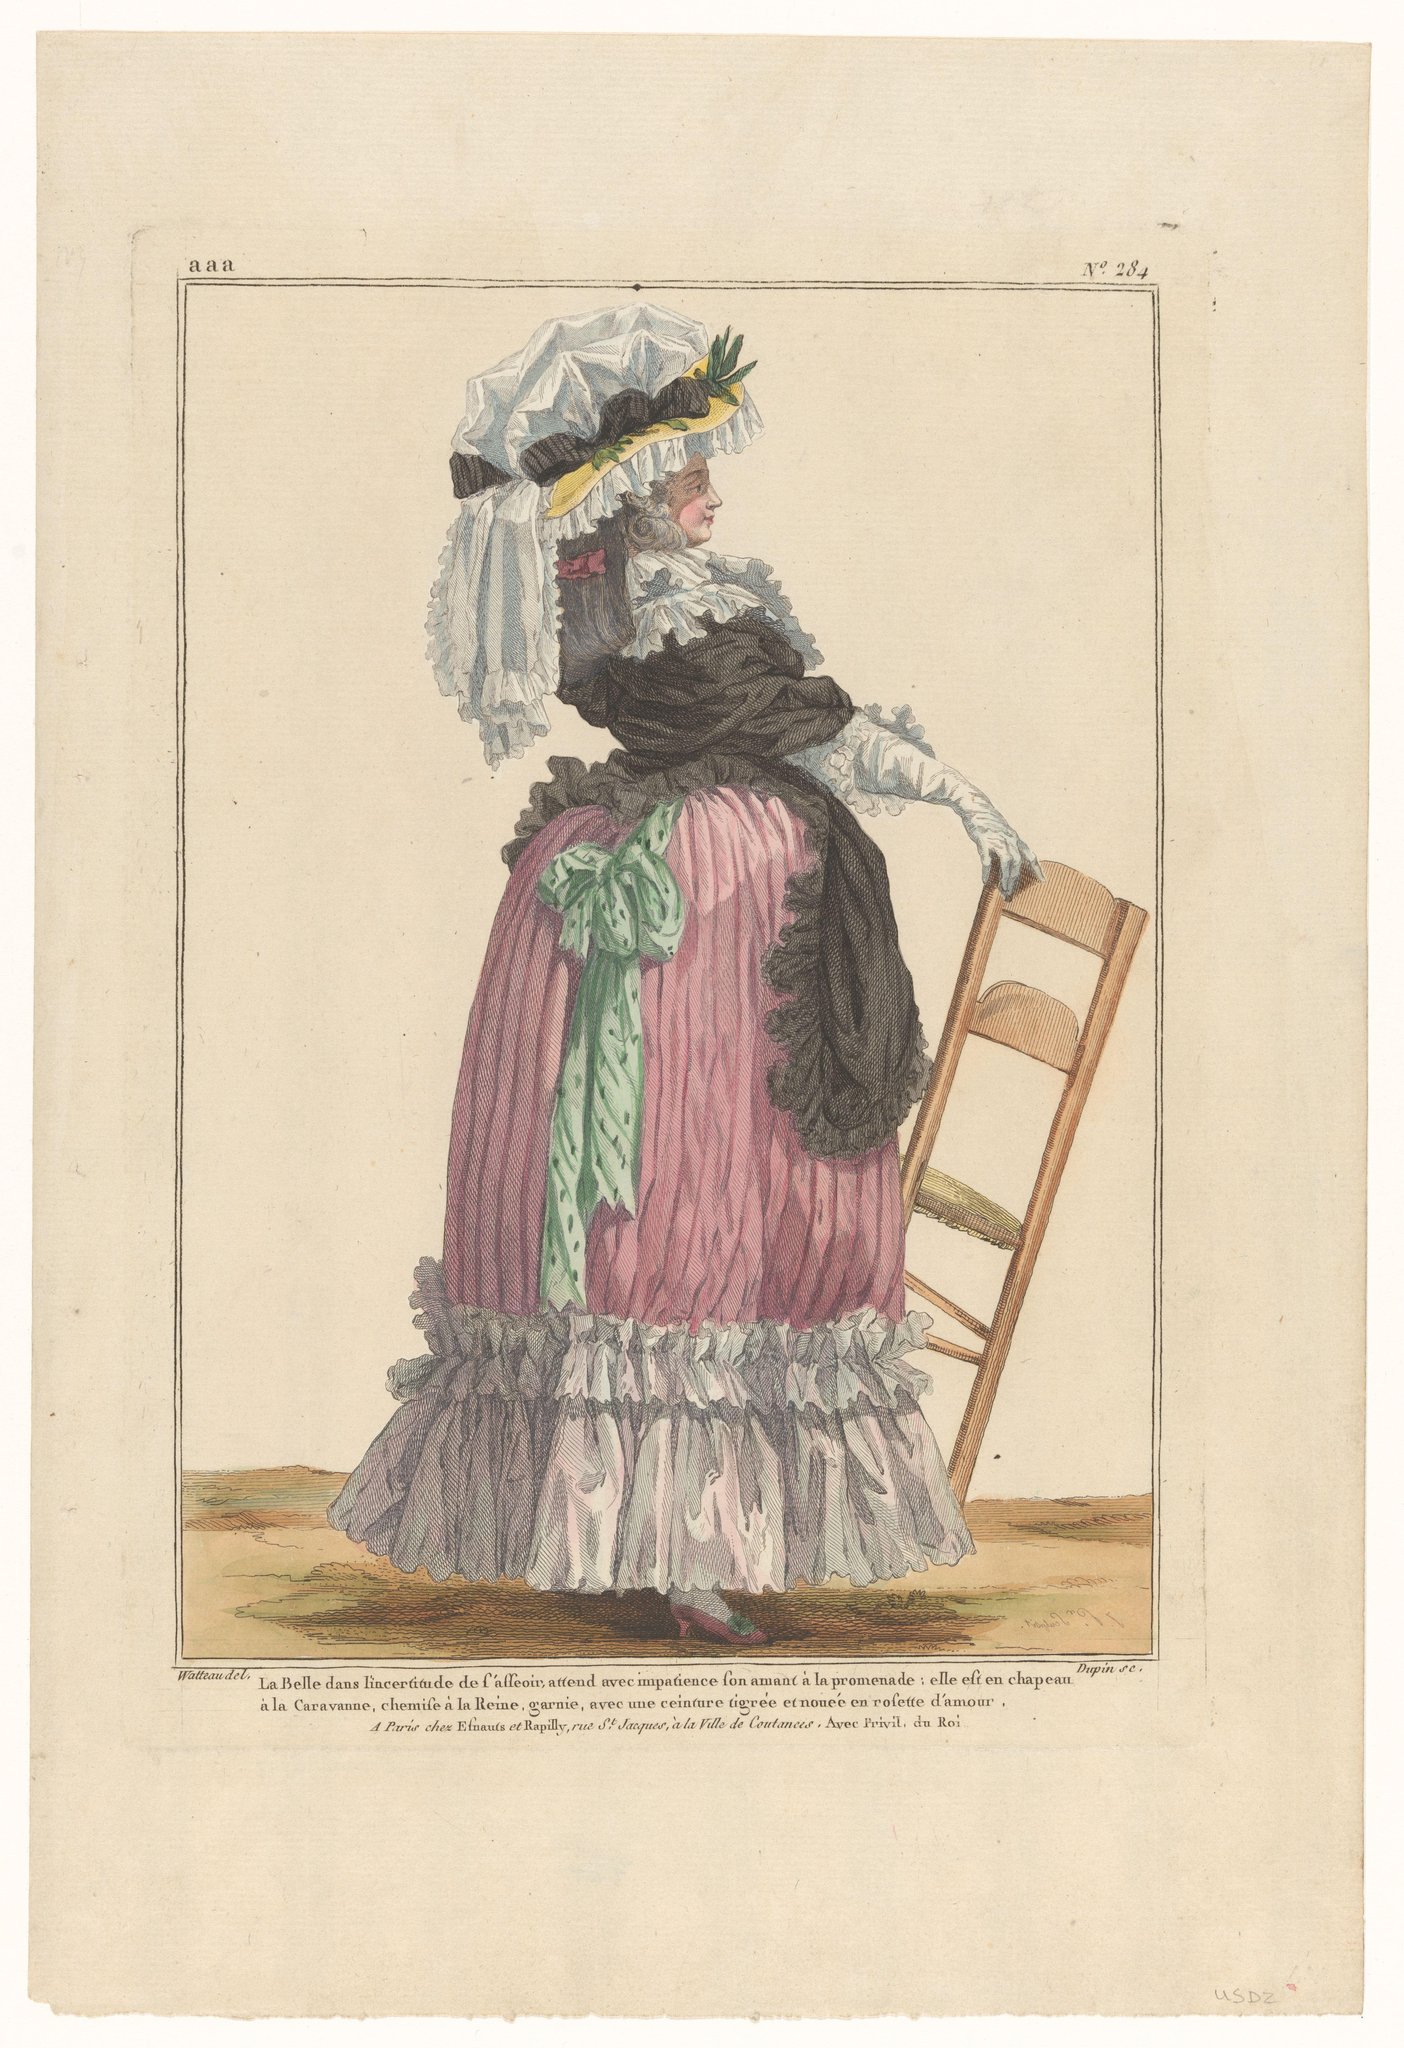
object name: fashion print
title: Gallerie des Modes et Costumes Français, 1785, aaa. 284: La Belle dans l'incertitud (...)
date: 1785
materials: paper, ink, watercolor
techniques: etching, hand coloring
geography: paris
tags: gloves, mittens (long gloves) (+ women's clothes), dress, gown: chemise à la reine (+ women's clothes), clothing for the upper part of the body (stola) (+ women's clothes), head-gear (bonnet) (+ women's clothes), fashion plates, shoes, sandals (+ women's clothes), piece of clothing covering the breast or décolleté (fichu) (+ women's clothes), belt, girdle, waistband (+ women's clothes)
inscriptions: title (possibly false): ‘La Belle dans l’incertitude de l’asseior, attend avec impatience son amant à la promenade: elle est en chapeau à la Caravanne, chemise à la Reine, garnie, avec une ceinture tigrée et nouée en rosette d’amour’, collector's mark: Lugt 2228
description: Een vrouw, ongeduldig wachtend op de komst van haar geliefde. Zij is gekleed in een roze chemise à la Reine, waarvan de onderkant van de rok is afgezet met een brede geplooide strook. Ceintuur van gespikkelde stof om de taille, in een strik (rosette d'amour) op de rug. Op het hoofd een grote muts met afhangende sluier die 'Chapeau à la Caravanne' wordt genoemd. Prent uit serie aaa. 45e Cahier de Costumes Français, 40e Suite d'Habillemens à la mode en 1785, Gallerie des Modes et Costumes Français.